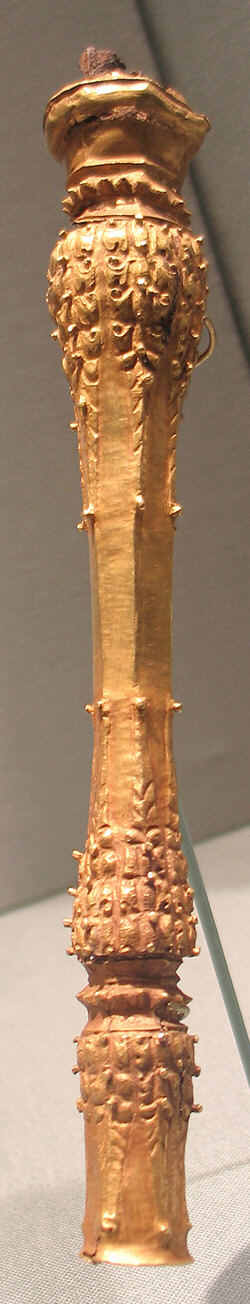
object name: sceptre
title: Sceptre with Iron Core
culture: indonesian, javanese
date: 701-933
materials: gold, iron